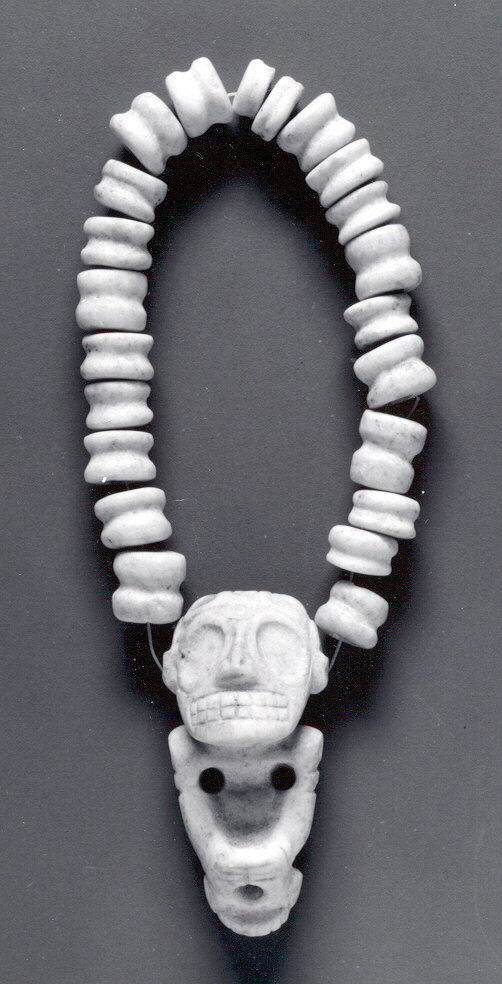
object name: pendant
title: Necklace with Pendant Figure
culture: taíno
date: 1201-1500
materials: stone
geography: dominican republic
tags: heads